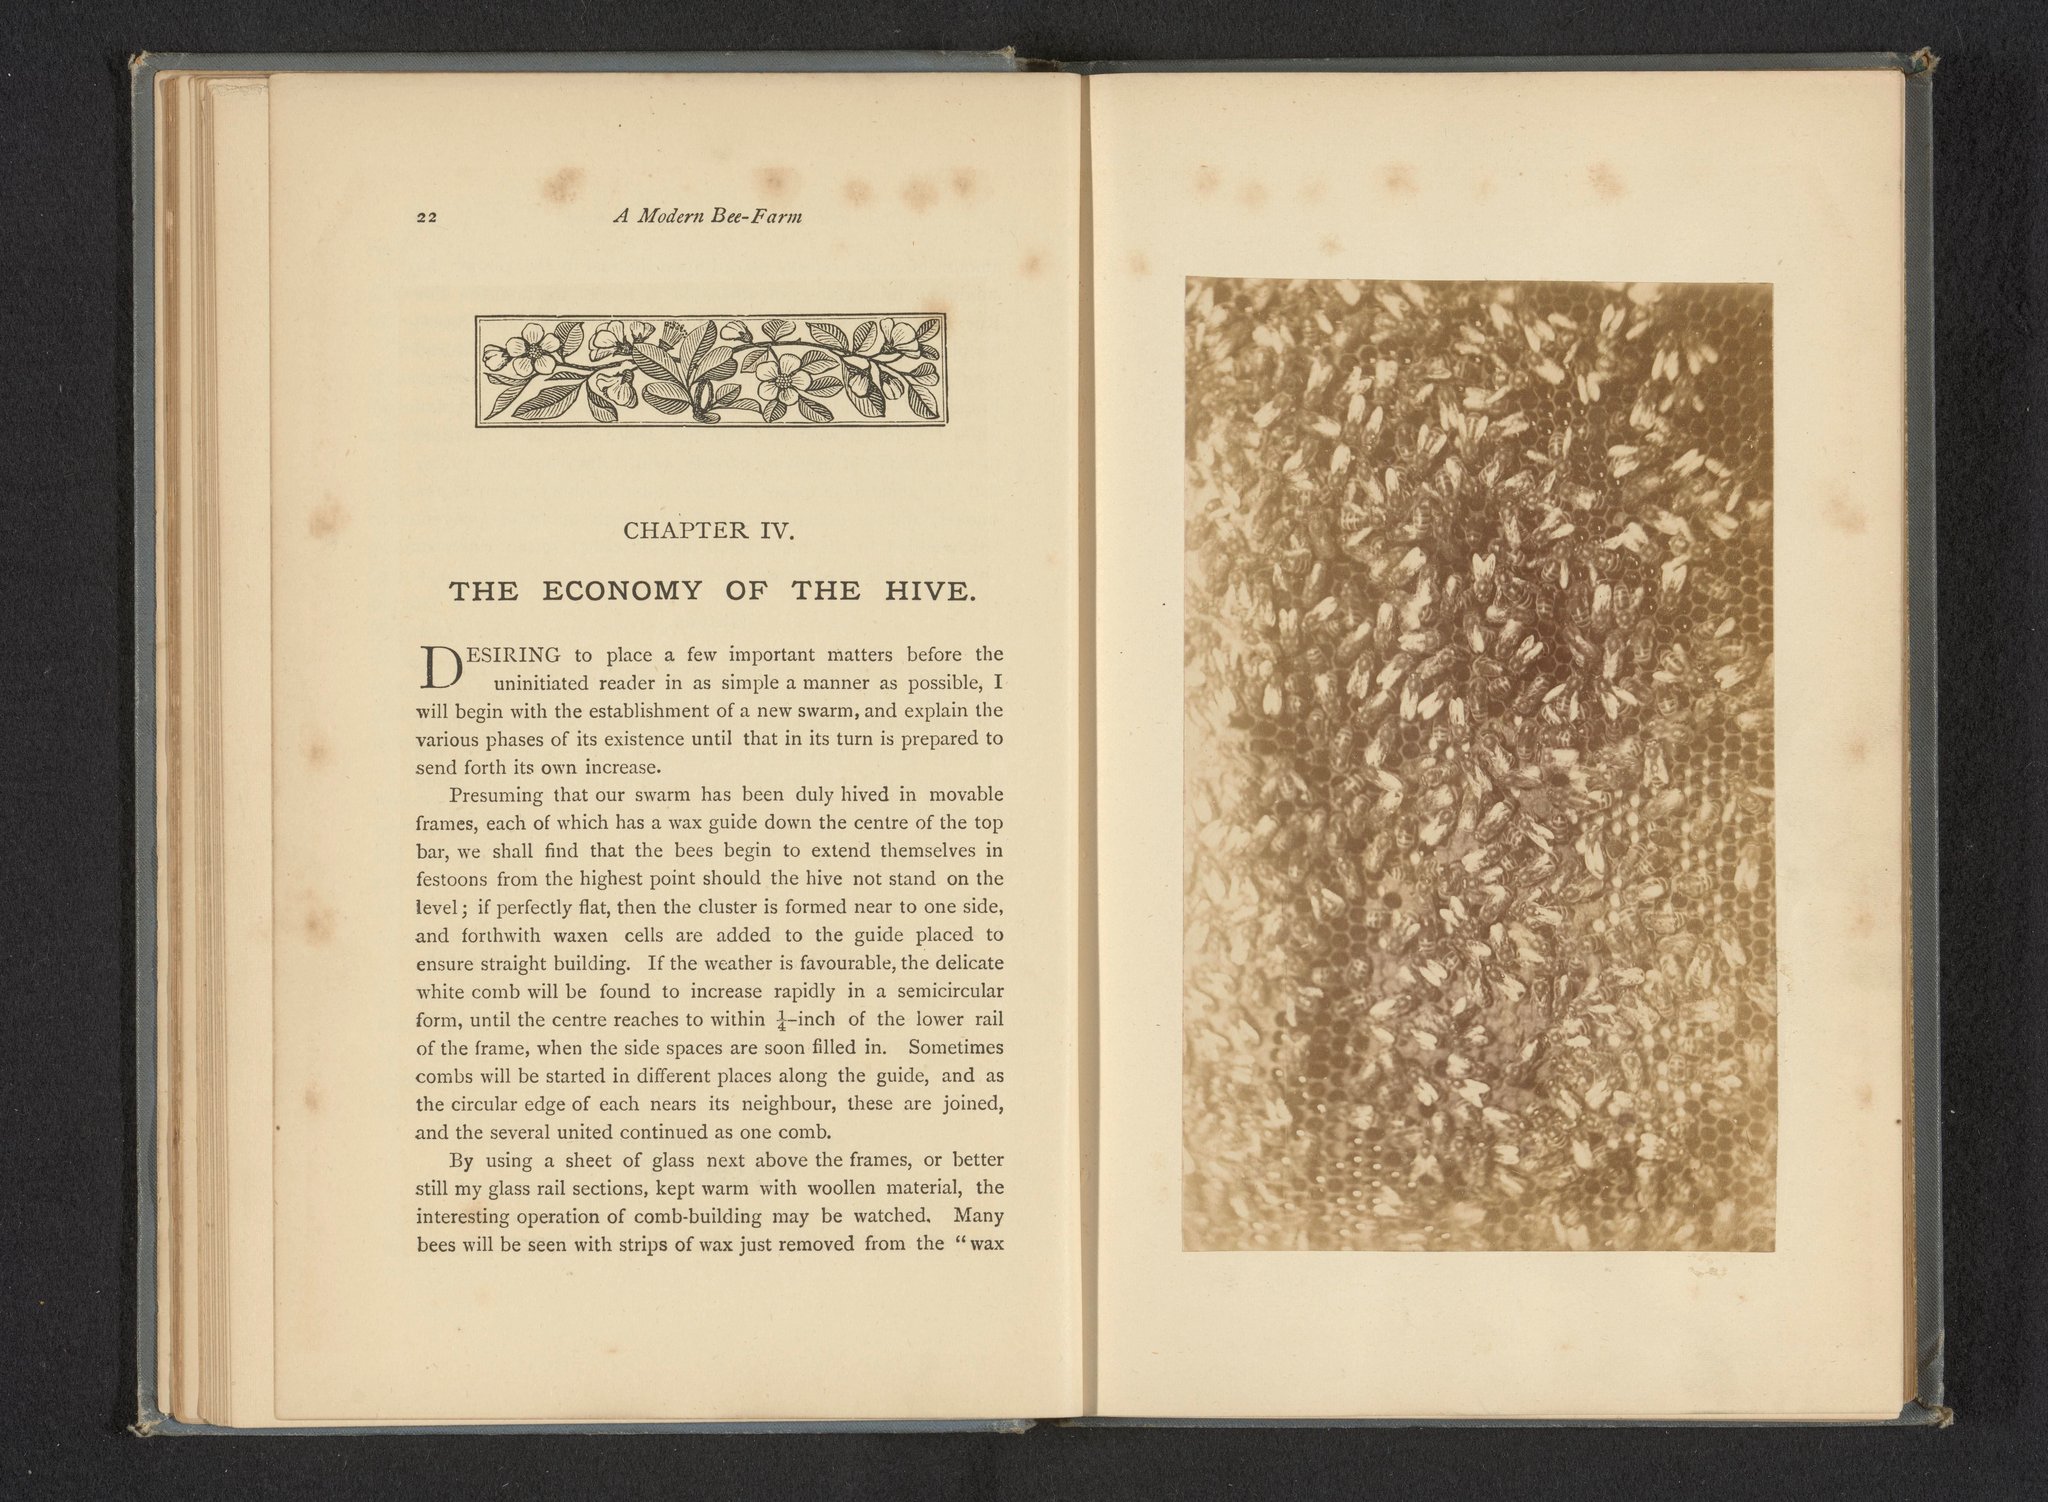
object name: photograph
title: Bijen op een honingraat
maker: Anonymous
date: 1882-1887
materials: photographic support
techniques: albumen print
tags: bee-hive, insects: bee